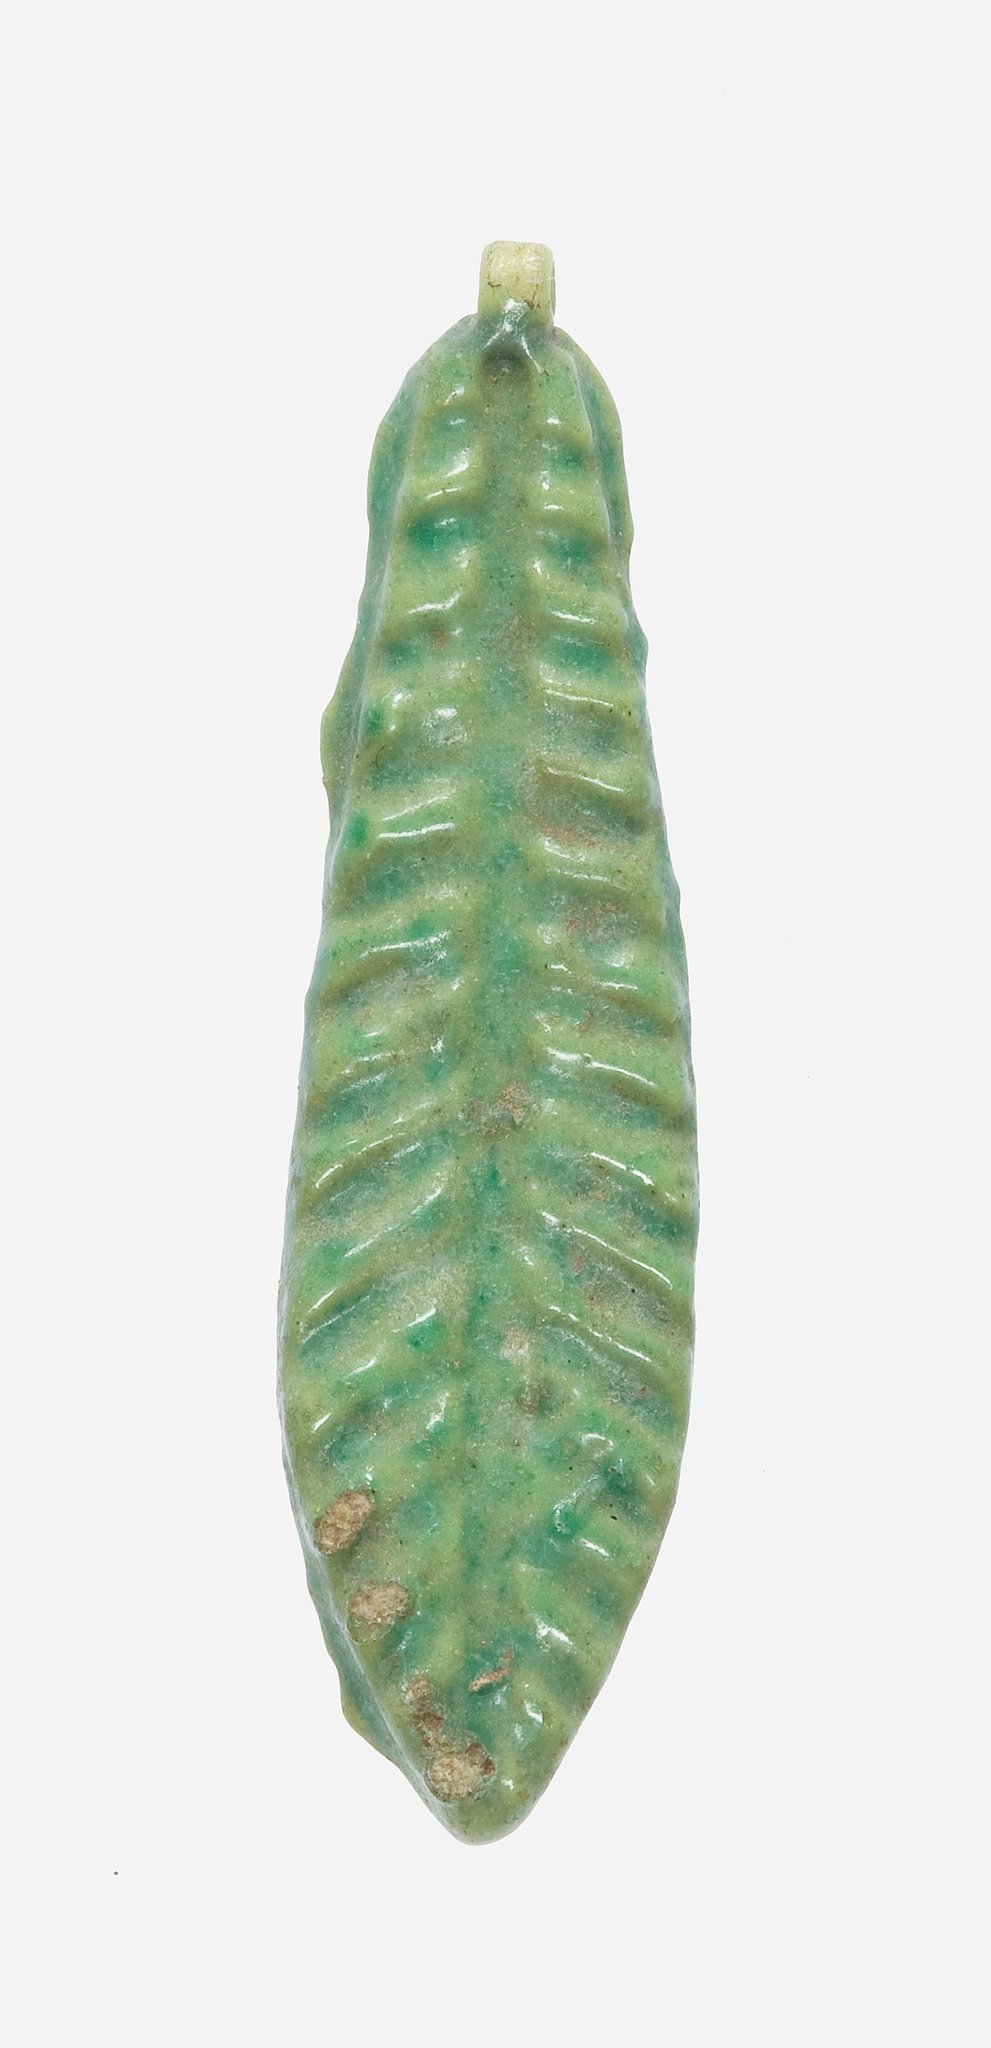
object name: bead, leaf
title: Bead in the Form of a Leaf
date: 1390-1352 BCE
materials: faience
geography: egypt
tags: leaves